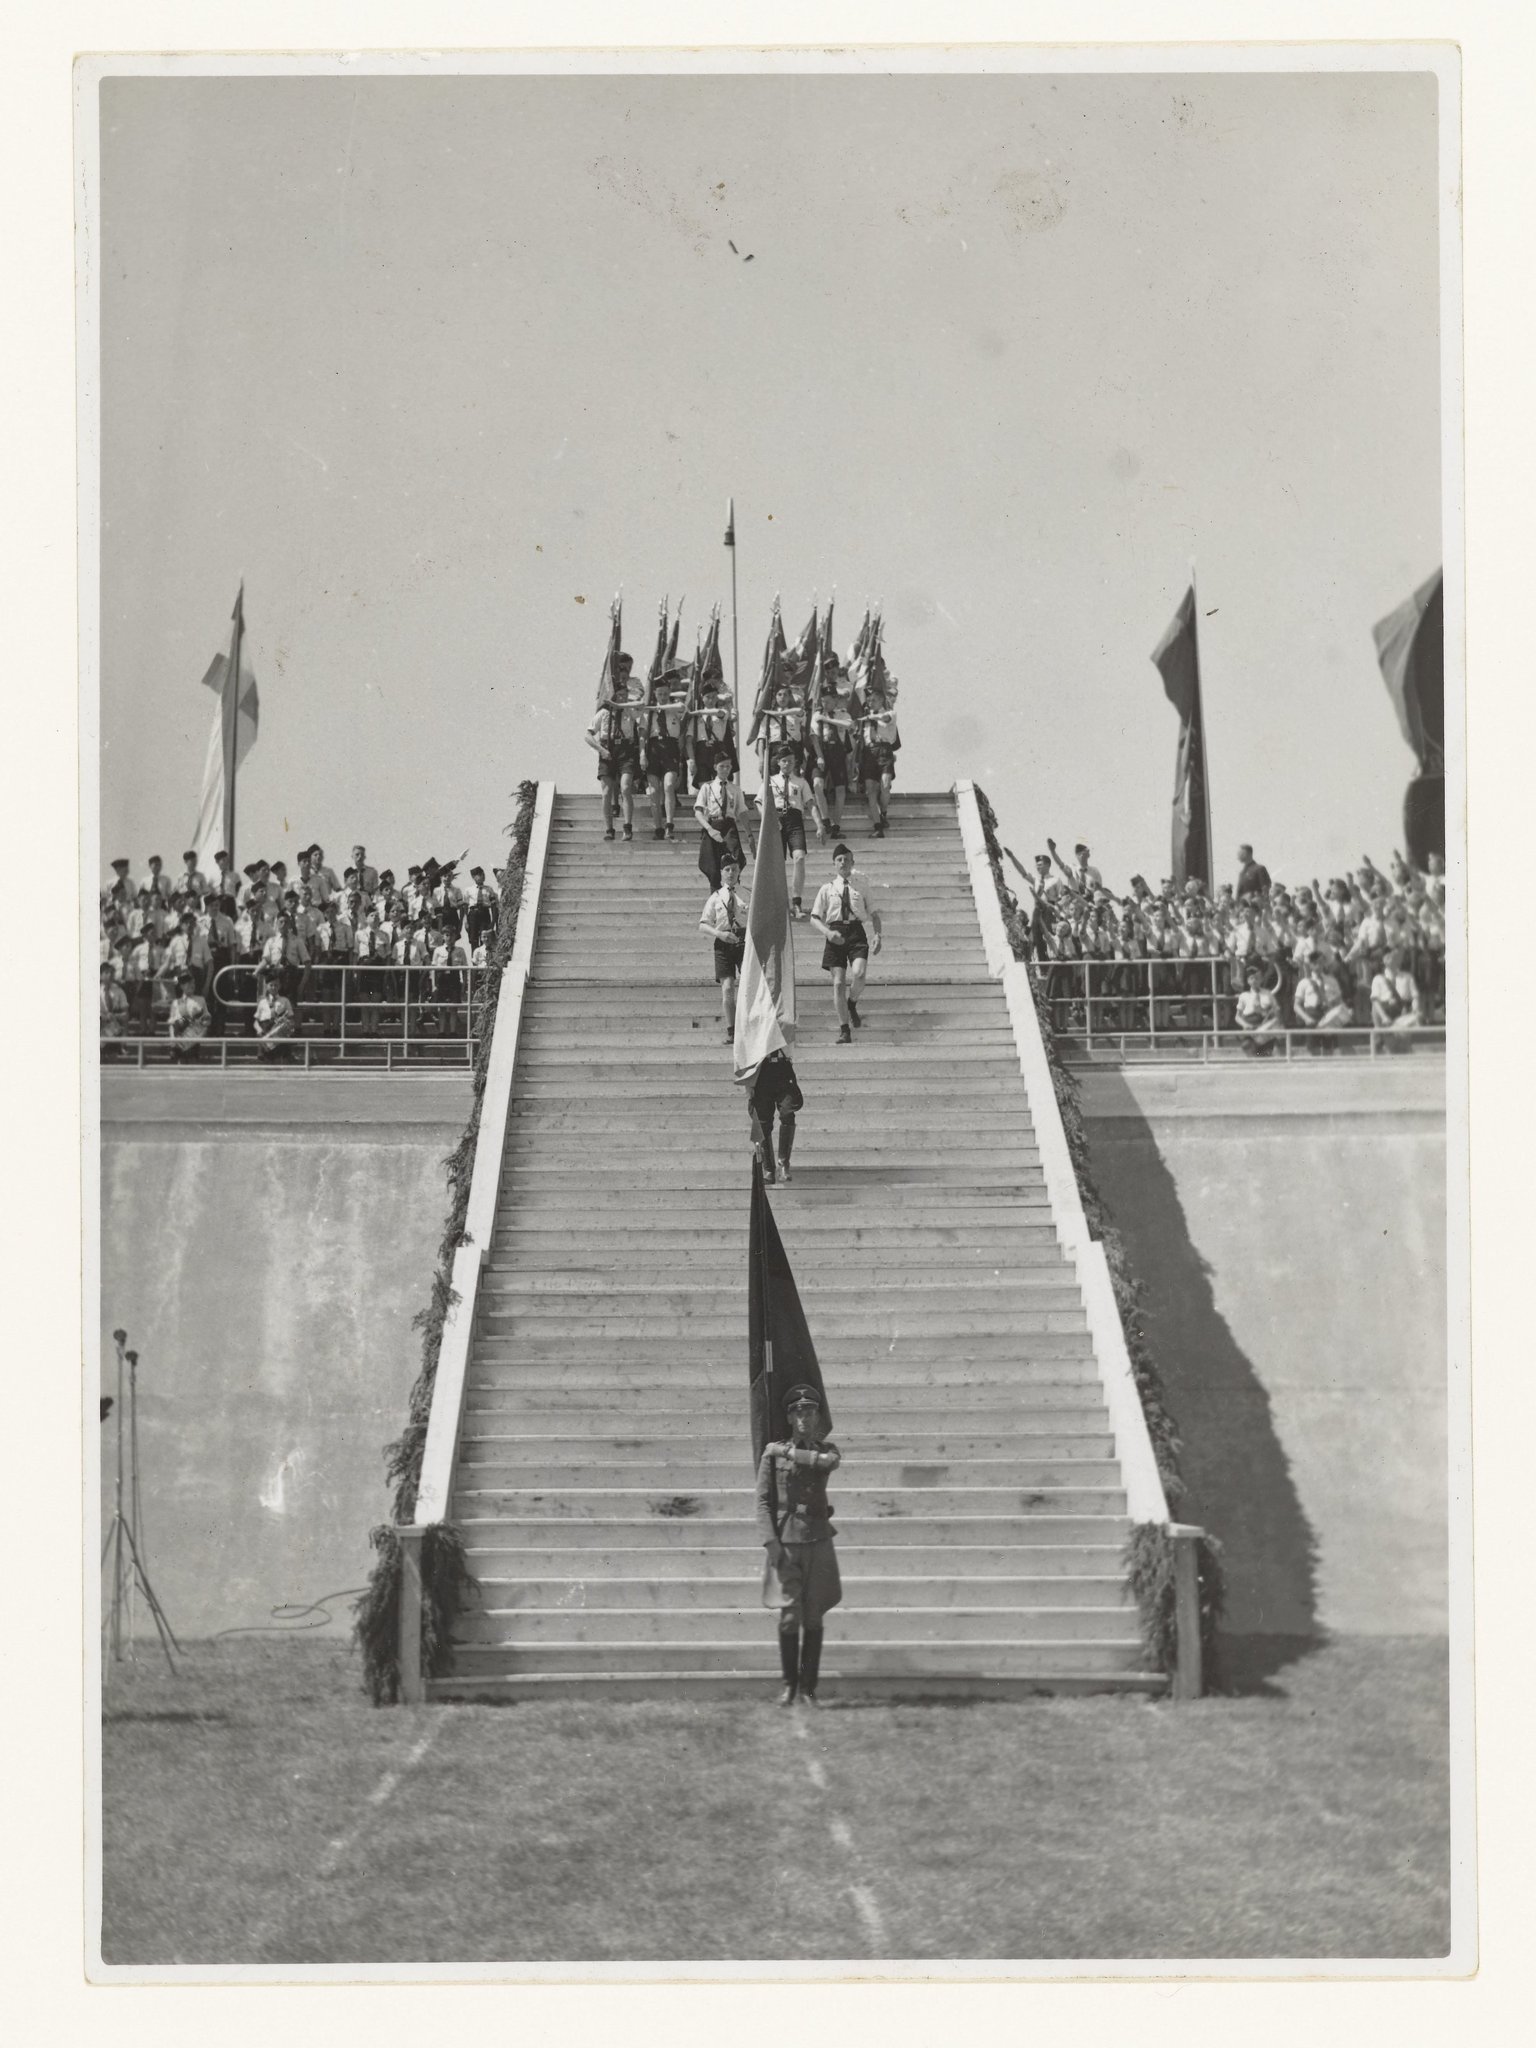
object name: photograph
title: Jeugdstorm in Stadion Galgenwaard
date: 1942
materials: photographic support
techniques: gelatin silver print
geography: utrecht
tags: politician, anton adriaan mussert, military parade, pageant, utrecht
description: Een lange rij leden van de Jeugdstorm komt de trap af in Stadion Galgenwaard in Utrecht op 20 juni 1942. In het stadion zullen zij de beëdiging van een 3000 kaderleden van de NSB bijwonen. Onderaan de trap staat een Wehrmachtsoldaat met een vlag. Op de tribunes, links en rechts van de trap zitten leden van de Jeugdstorm. Een deel brengt de NSB groet: gestrekte arm zoals de Hitlergroet en roepen: Houzee. De ceremonie van de eedsaflegging was het gevolg van een compromis tussen de Duitsers en de NSB. De Duitsers wilden een eed op Hitler (wat Mussert stiekem enigte tijd daarvoor had gedaan) de NSB niet. Compromis: Nederlandse SSers legden de eed op Hitler af, kaderleden van de NSB op Mussert.